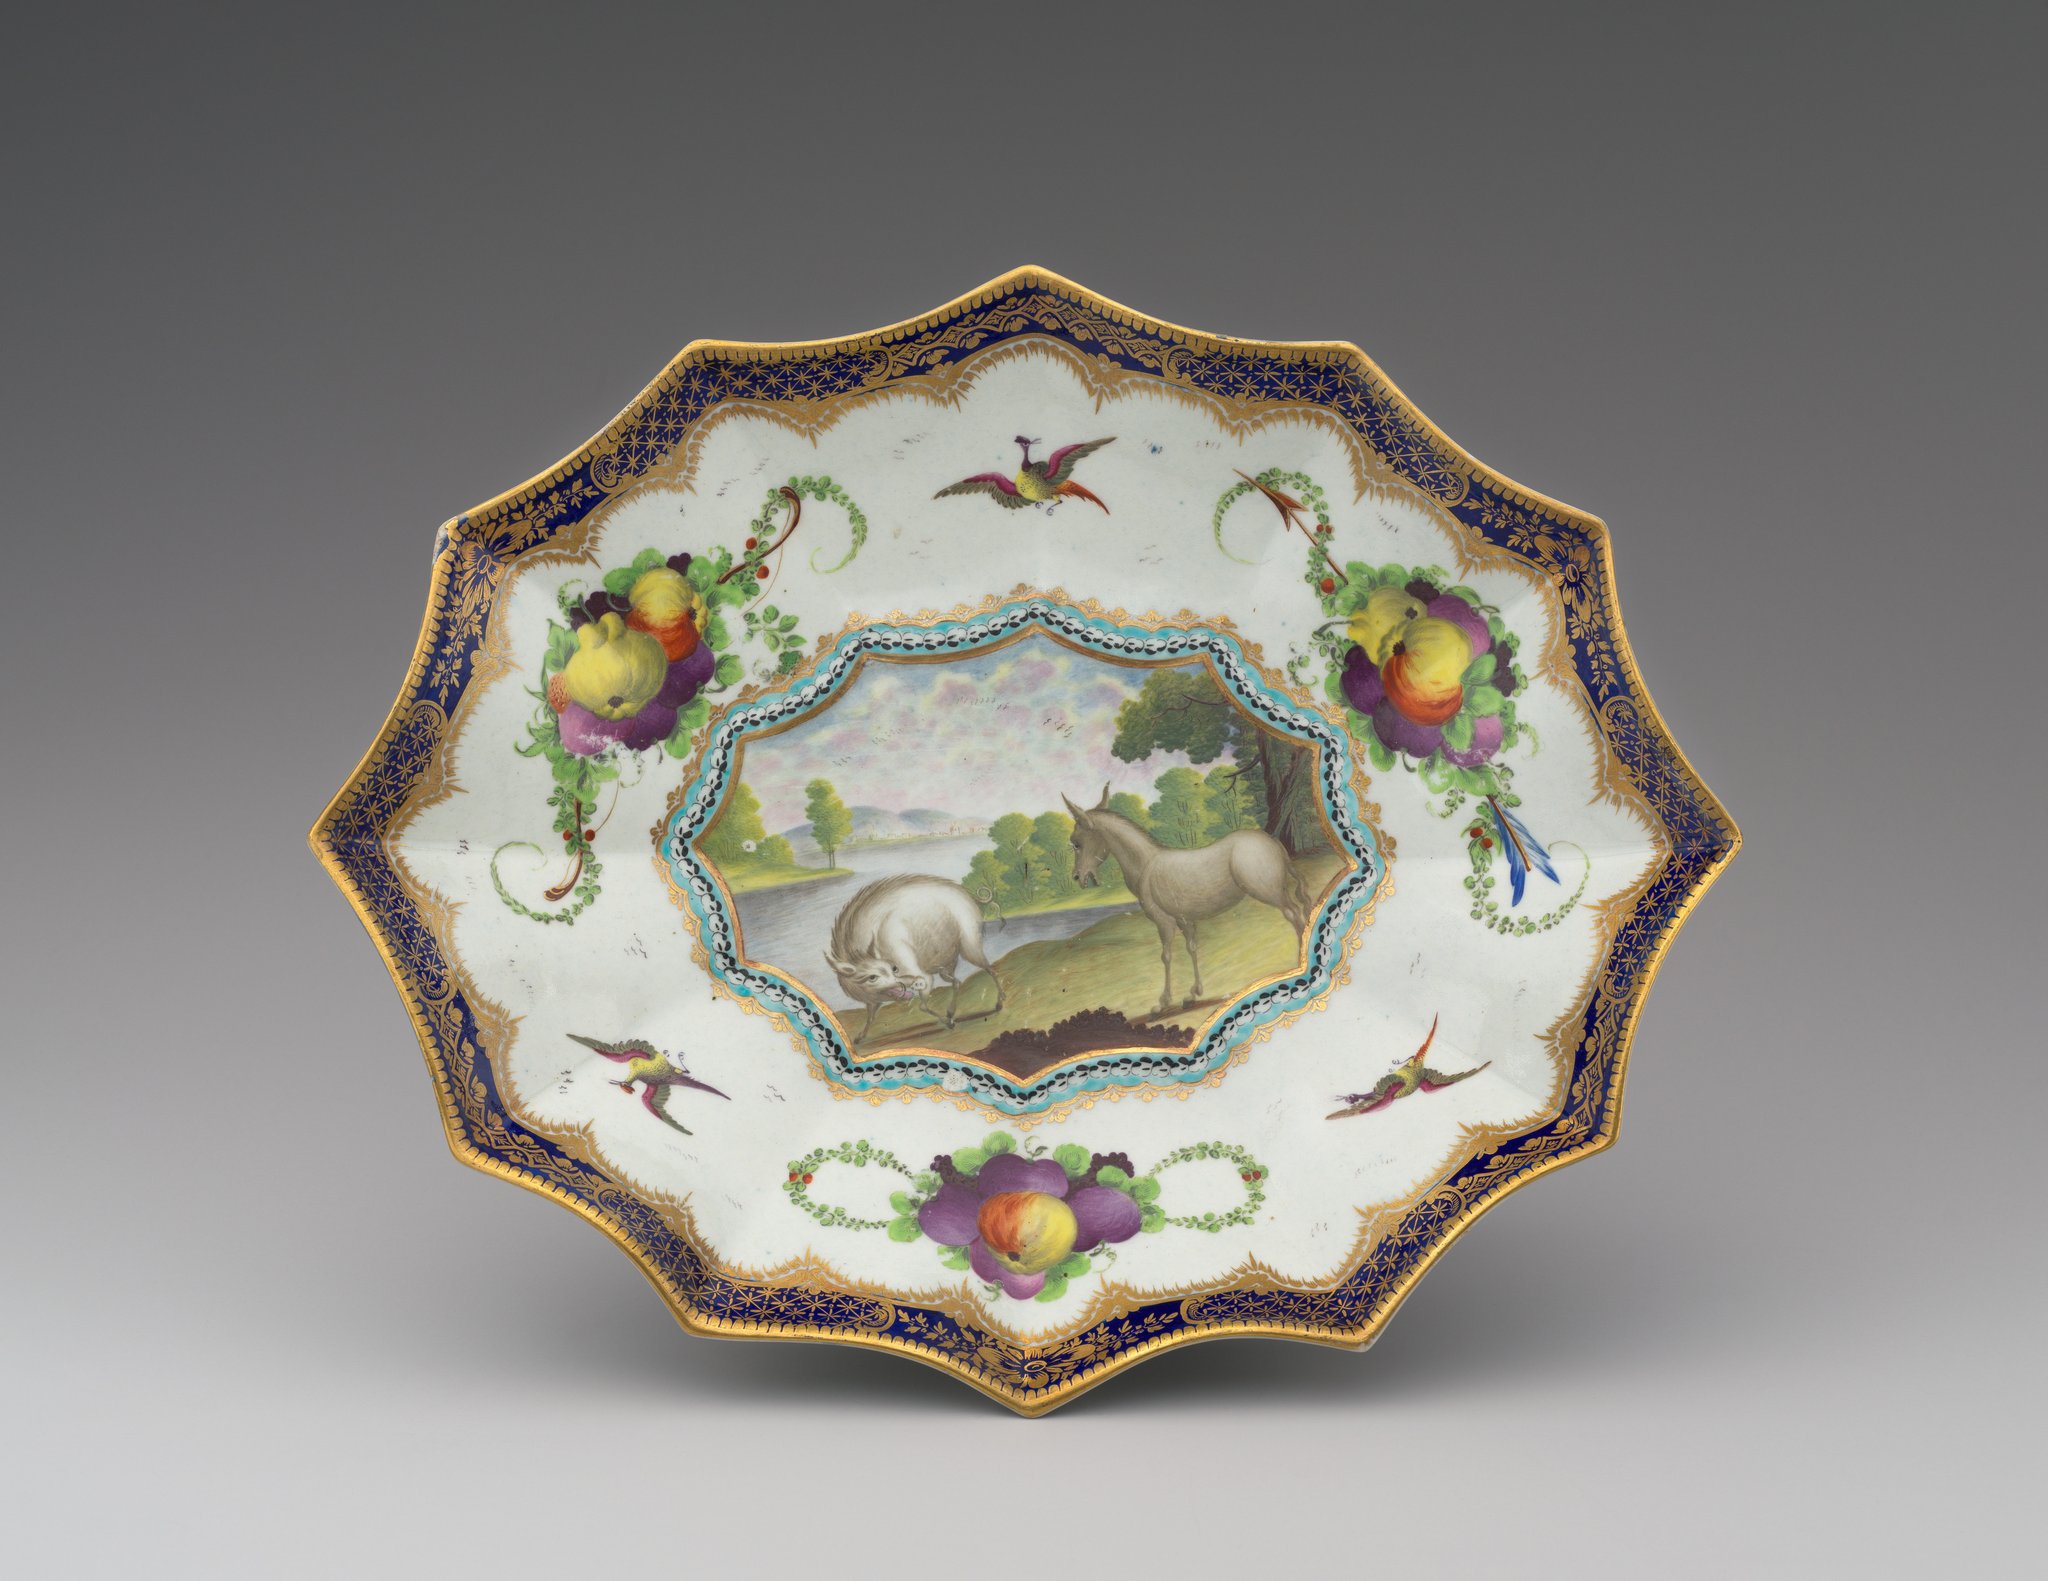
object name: dish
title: Dish (one of a pair)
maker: worcester factory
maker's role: factory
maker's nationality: british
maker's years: 1751-2008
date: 1770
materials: soft paste porcelain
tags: animals,birds,flowers